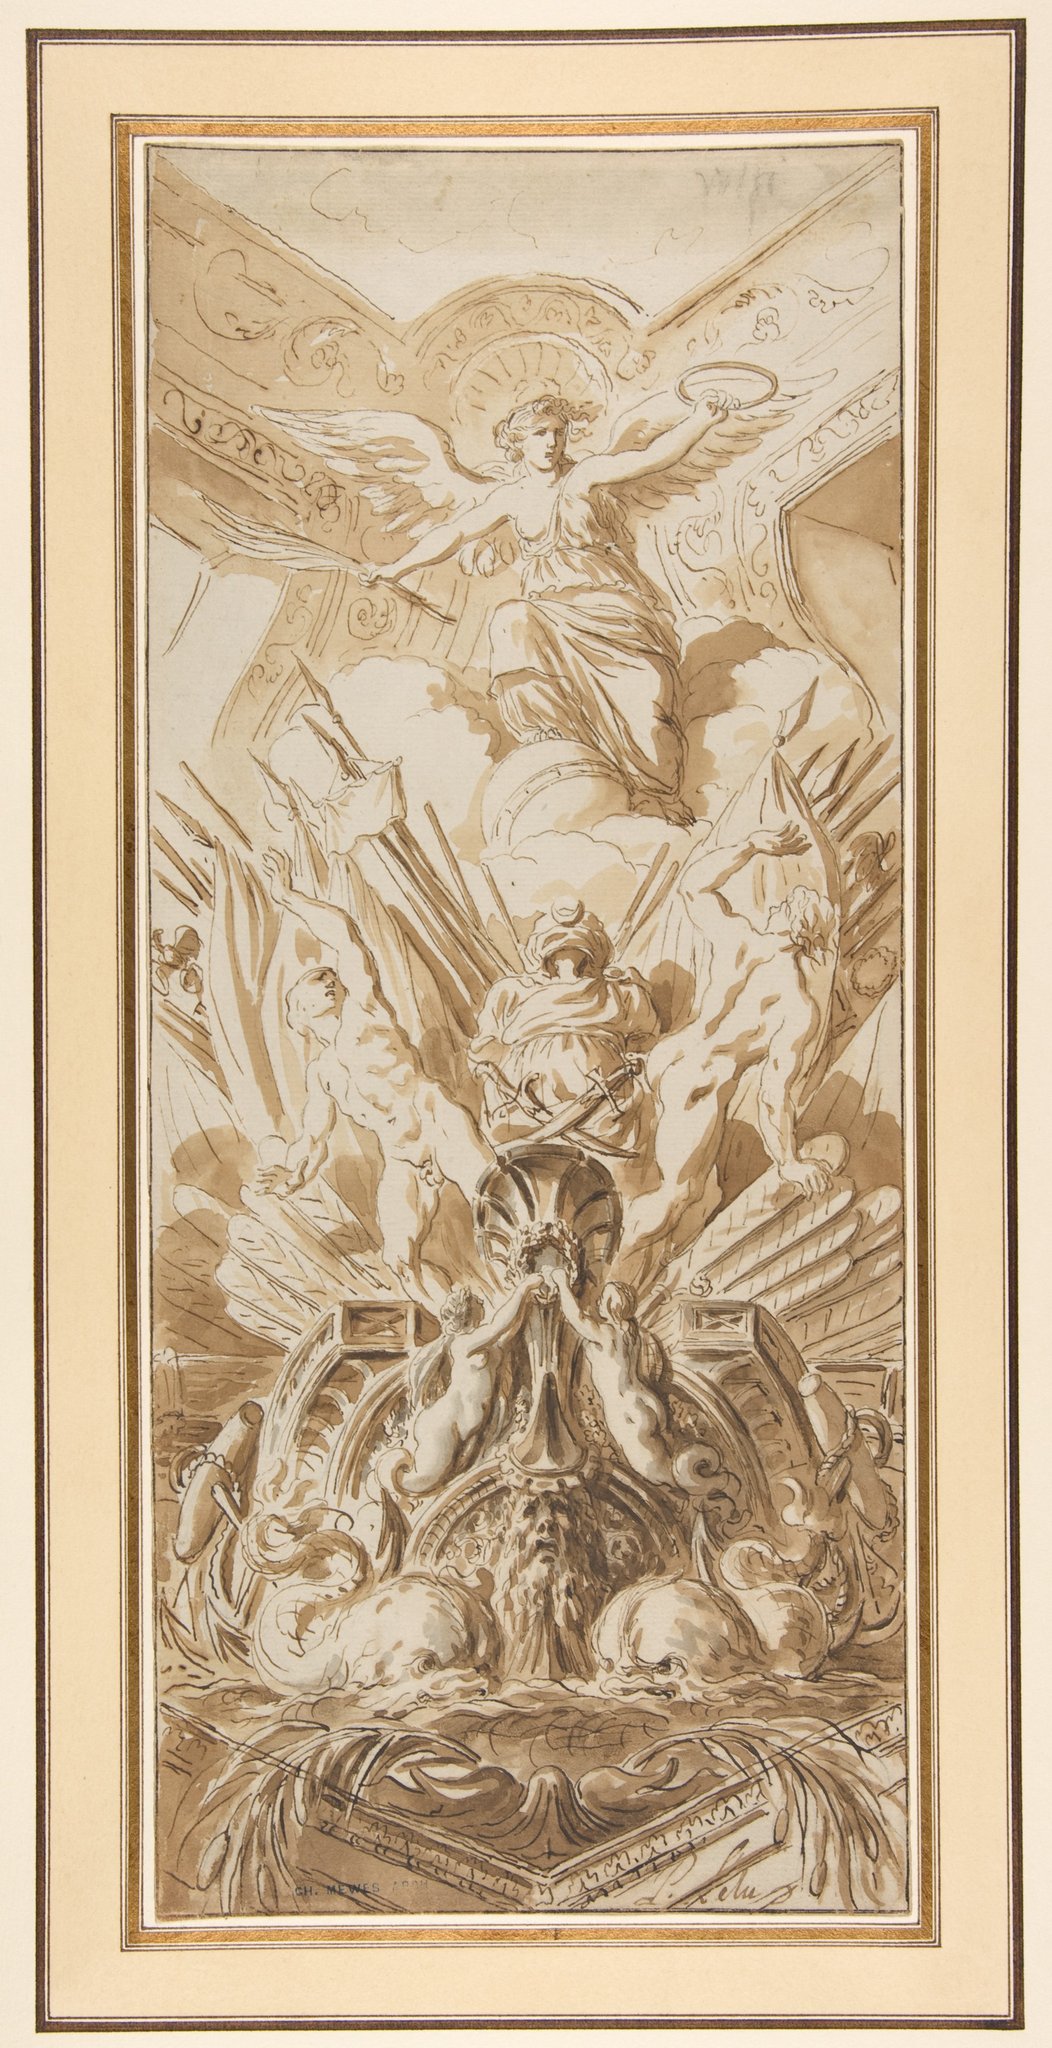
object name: drawing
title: Corner of the Ambassador's Staircase at Versailles (recto); Sketches of Figures and Dolphins (verso)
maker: pierre lélu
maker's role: artist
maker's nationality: french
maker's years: 1741-1810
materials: chalk, ink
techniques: brush, pen, wash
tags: male nudes,mythical creatures,dolphins